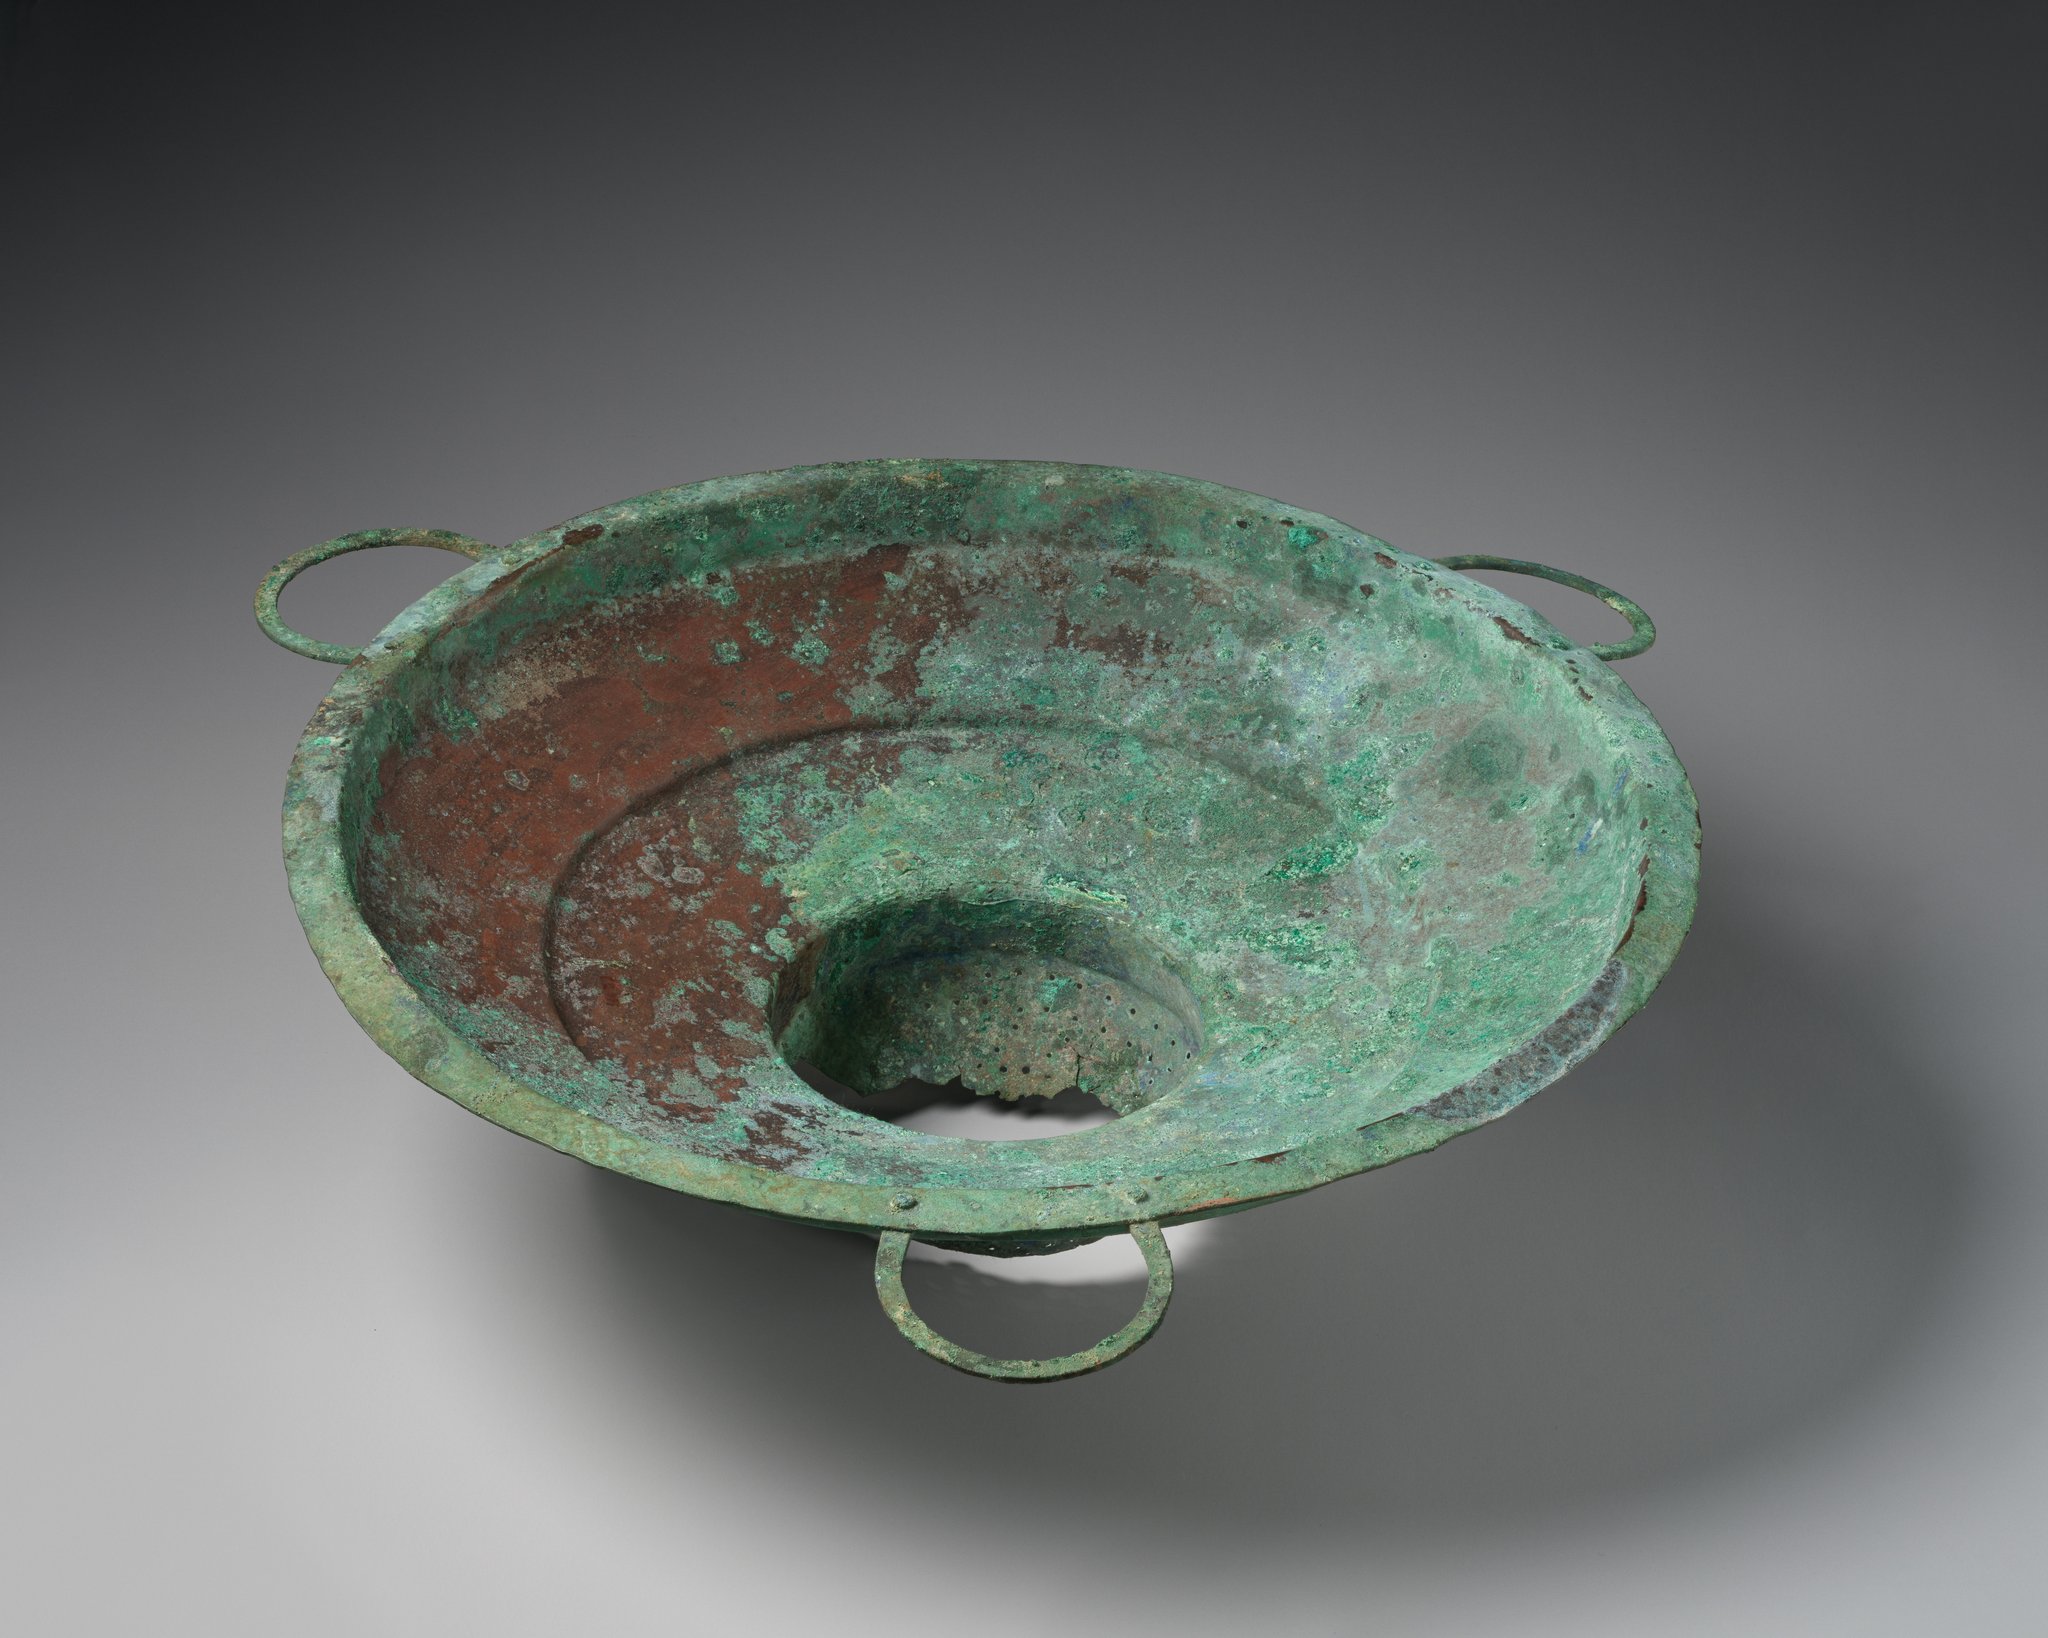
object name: strainer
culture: cypriot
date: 1000-901 BCE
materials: bronze